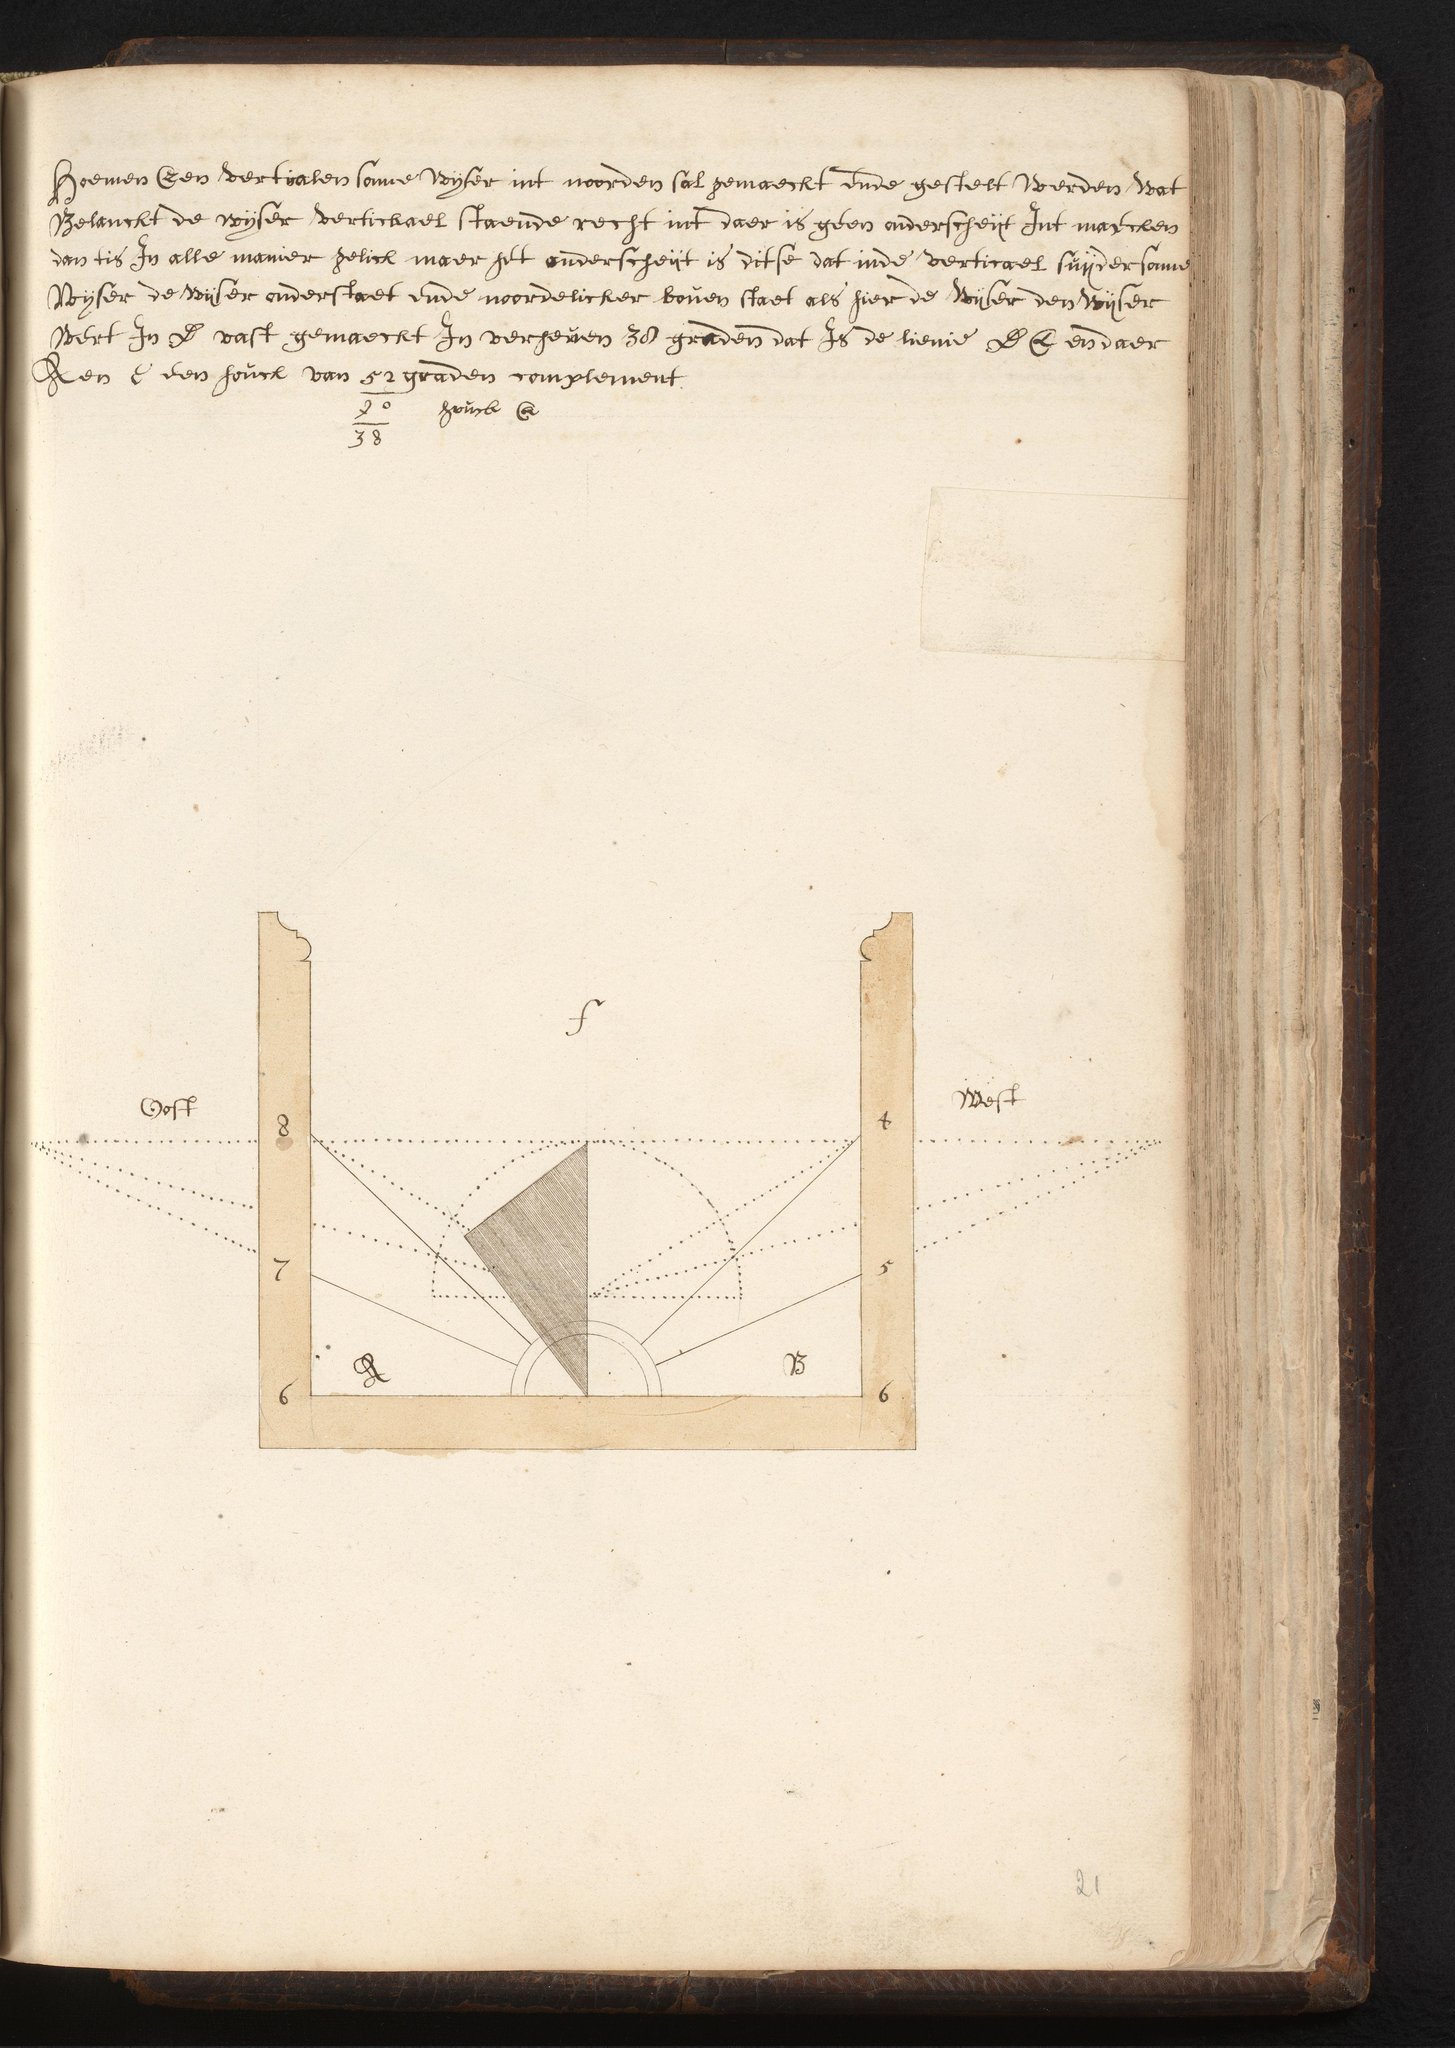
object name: album leaf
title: Hoemen een verticalen sonnewijser int noorden sal gemaeckt (...)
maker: Anonymous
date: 1650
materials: ink, paper, pencil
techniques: brush, pen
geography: low countries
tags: sundial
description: Met berekeningen. Tekening maakt deel uit van een album.